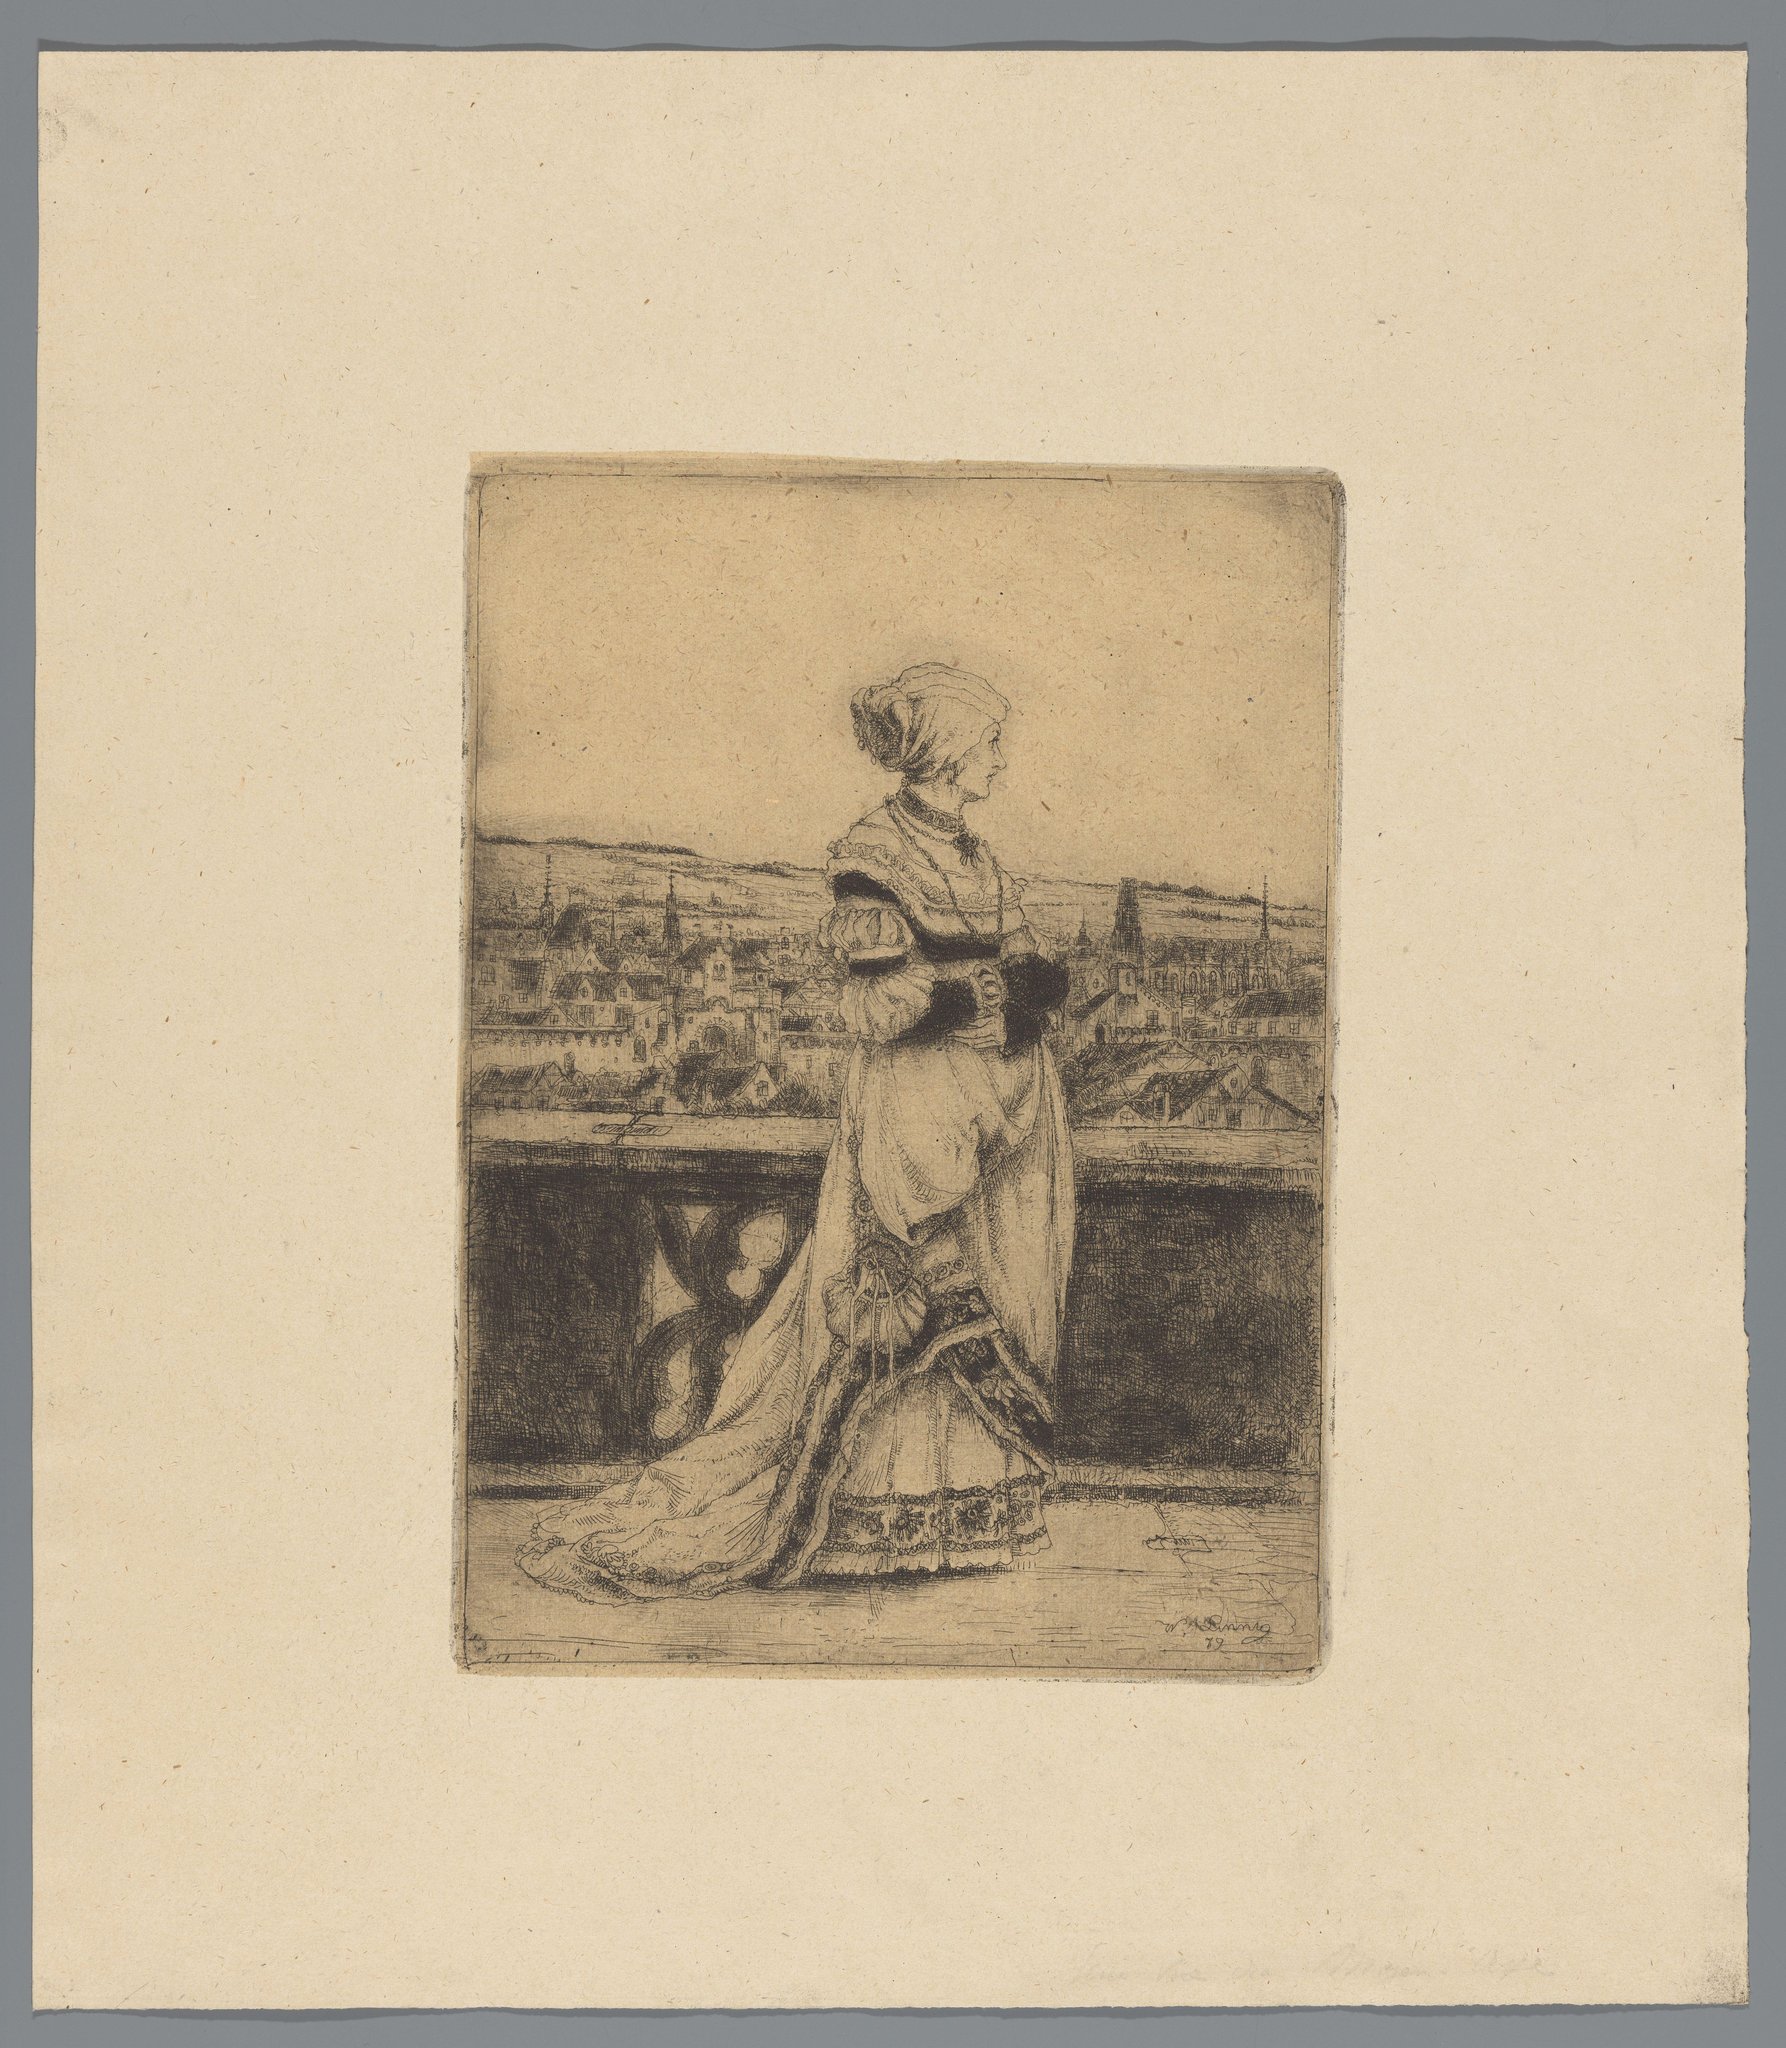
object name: print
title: Dame wandelend op een terras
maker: willem linnig (ii)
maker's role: print maker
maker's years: 1842-1890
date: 1879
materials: paper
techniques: etching, intaglio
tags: adult woman, walking, hiking (recreation)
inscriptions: collector's mark: Lugt 2228